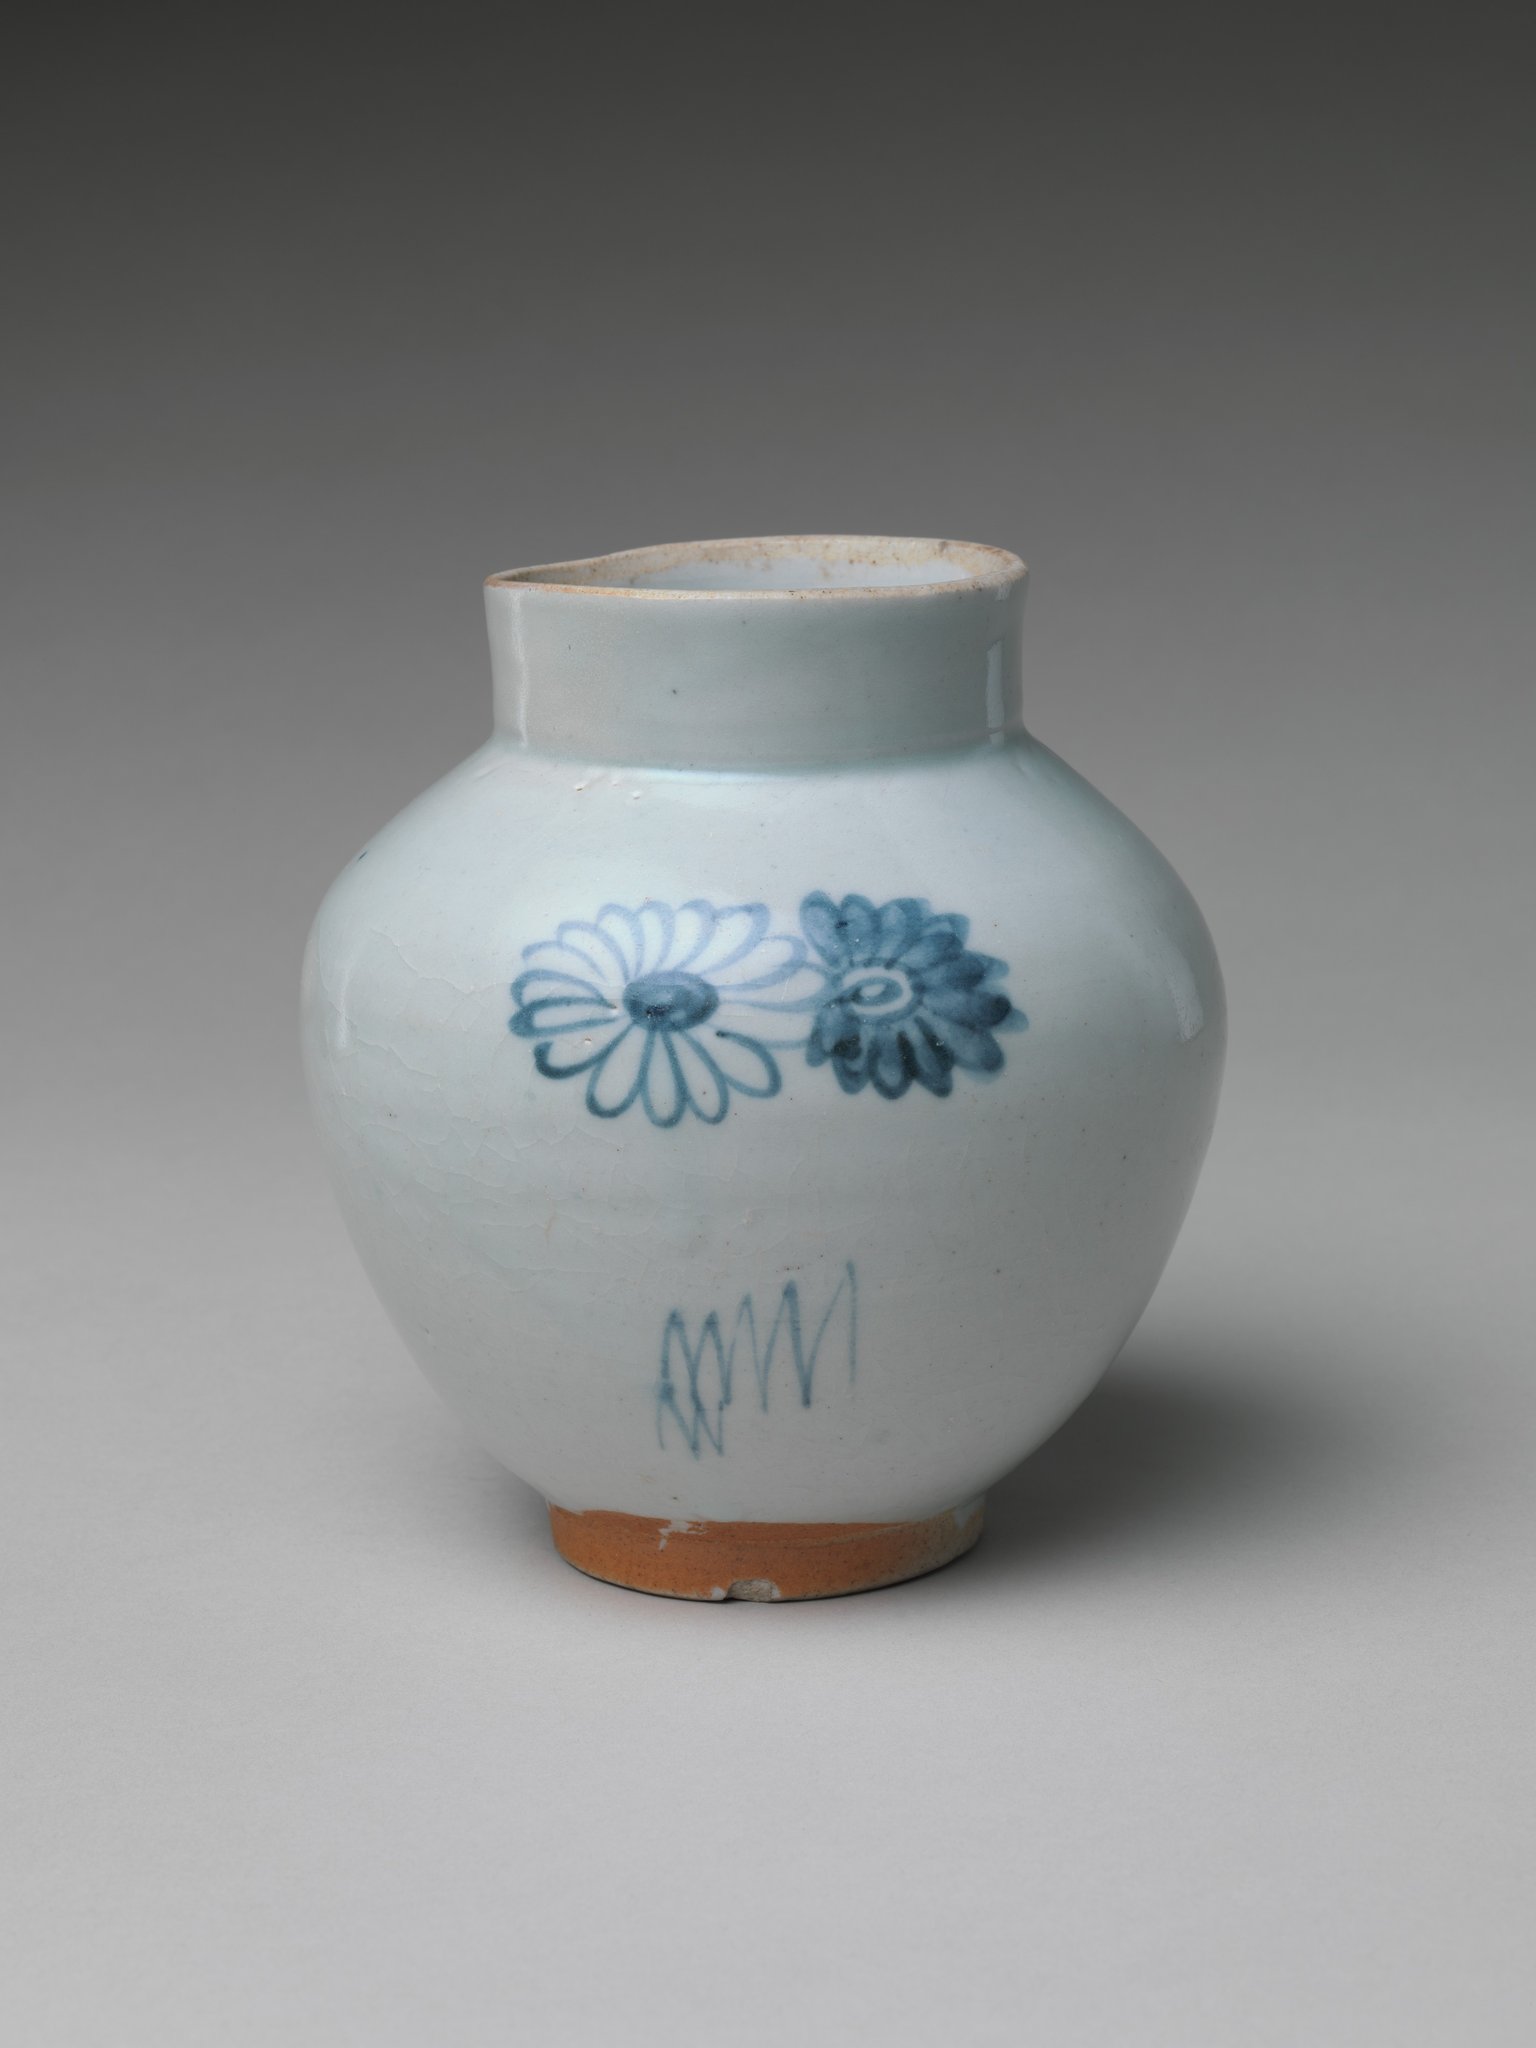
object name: jar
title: Jar with Chrysanthemums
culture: japanese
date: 1601-1700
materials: porcelain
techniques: painting, underglaze